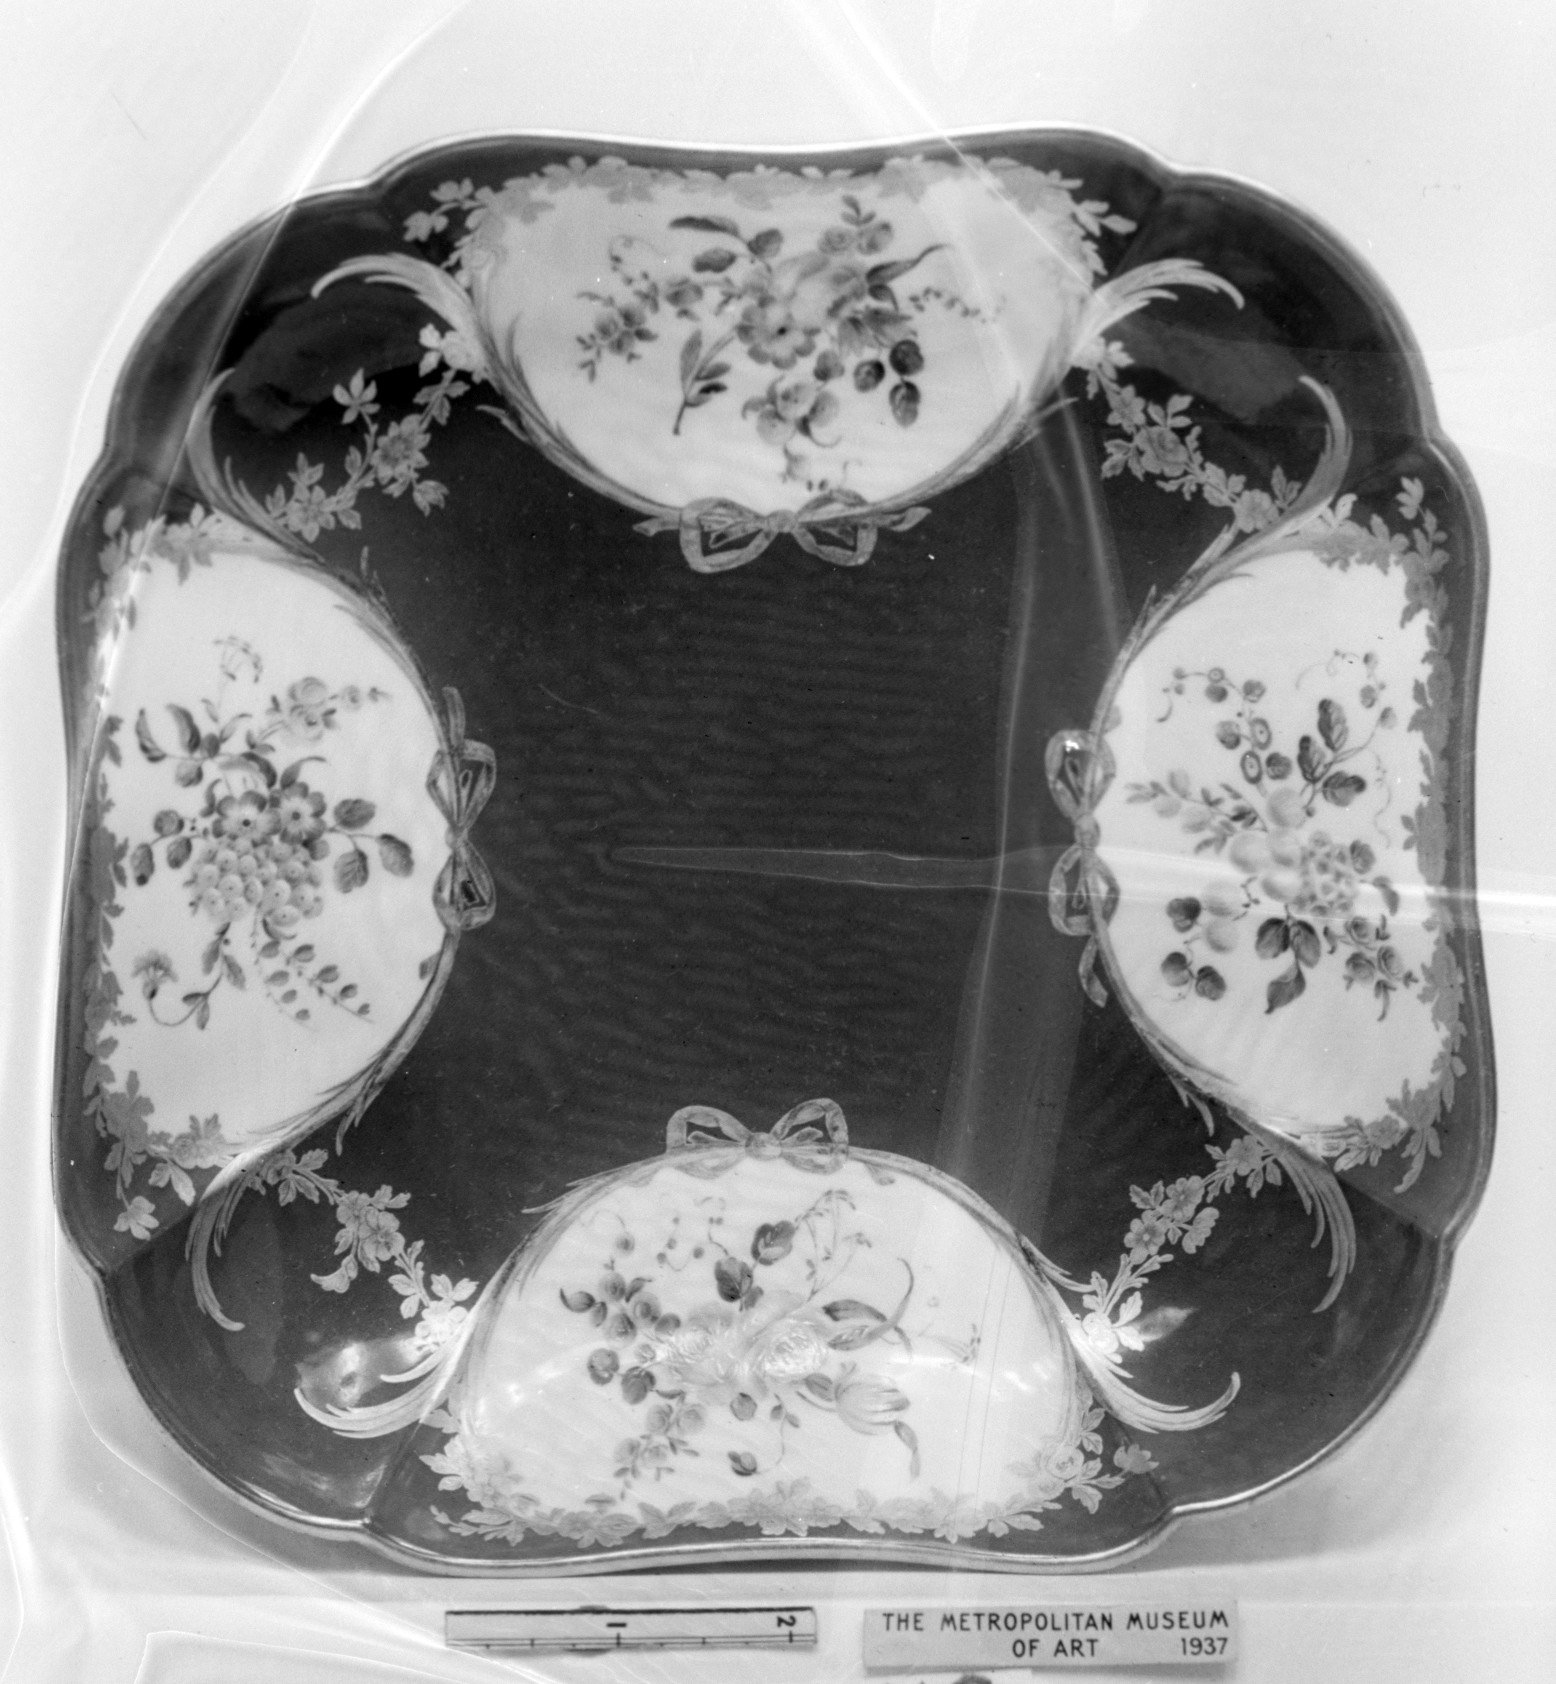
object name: fruit dish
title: Fruit dish (part of a service)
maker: sèvres manufactory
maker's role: manufactory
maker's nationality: french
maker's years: 1740-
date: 1772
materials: hard paste porcelain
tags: flowers